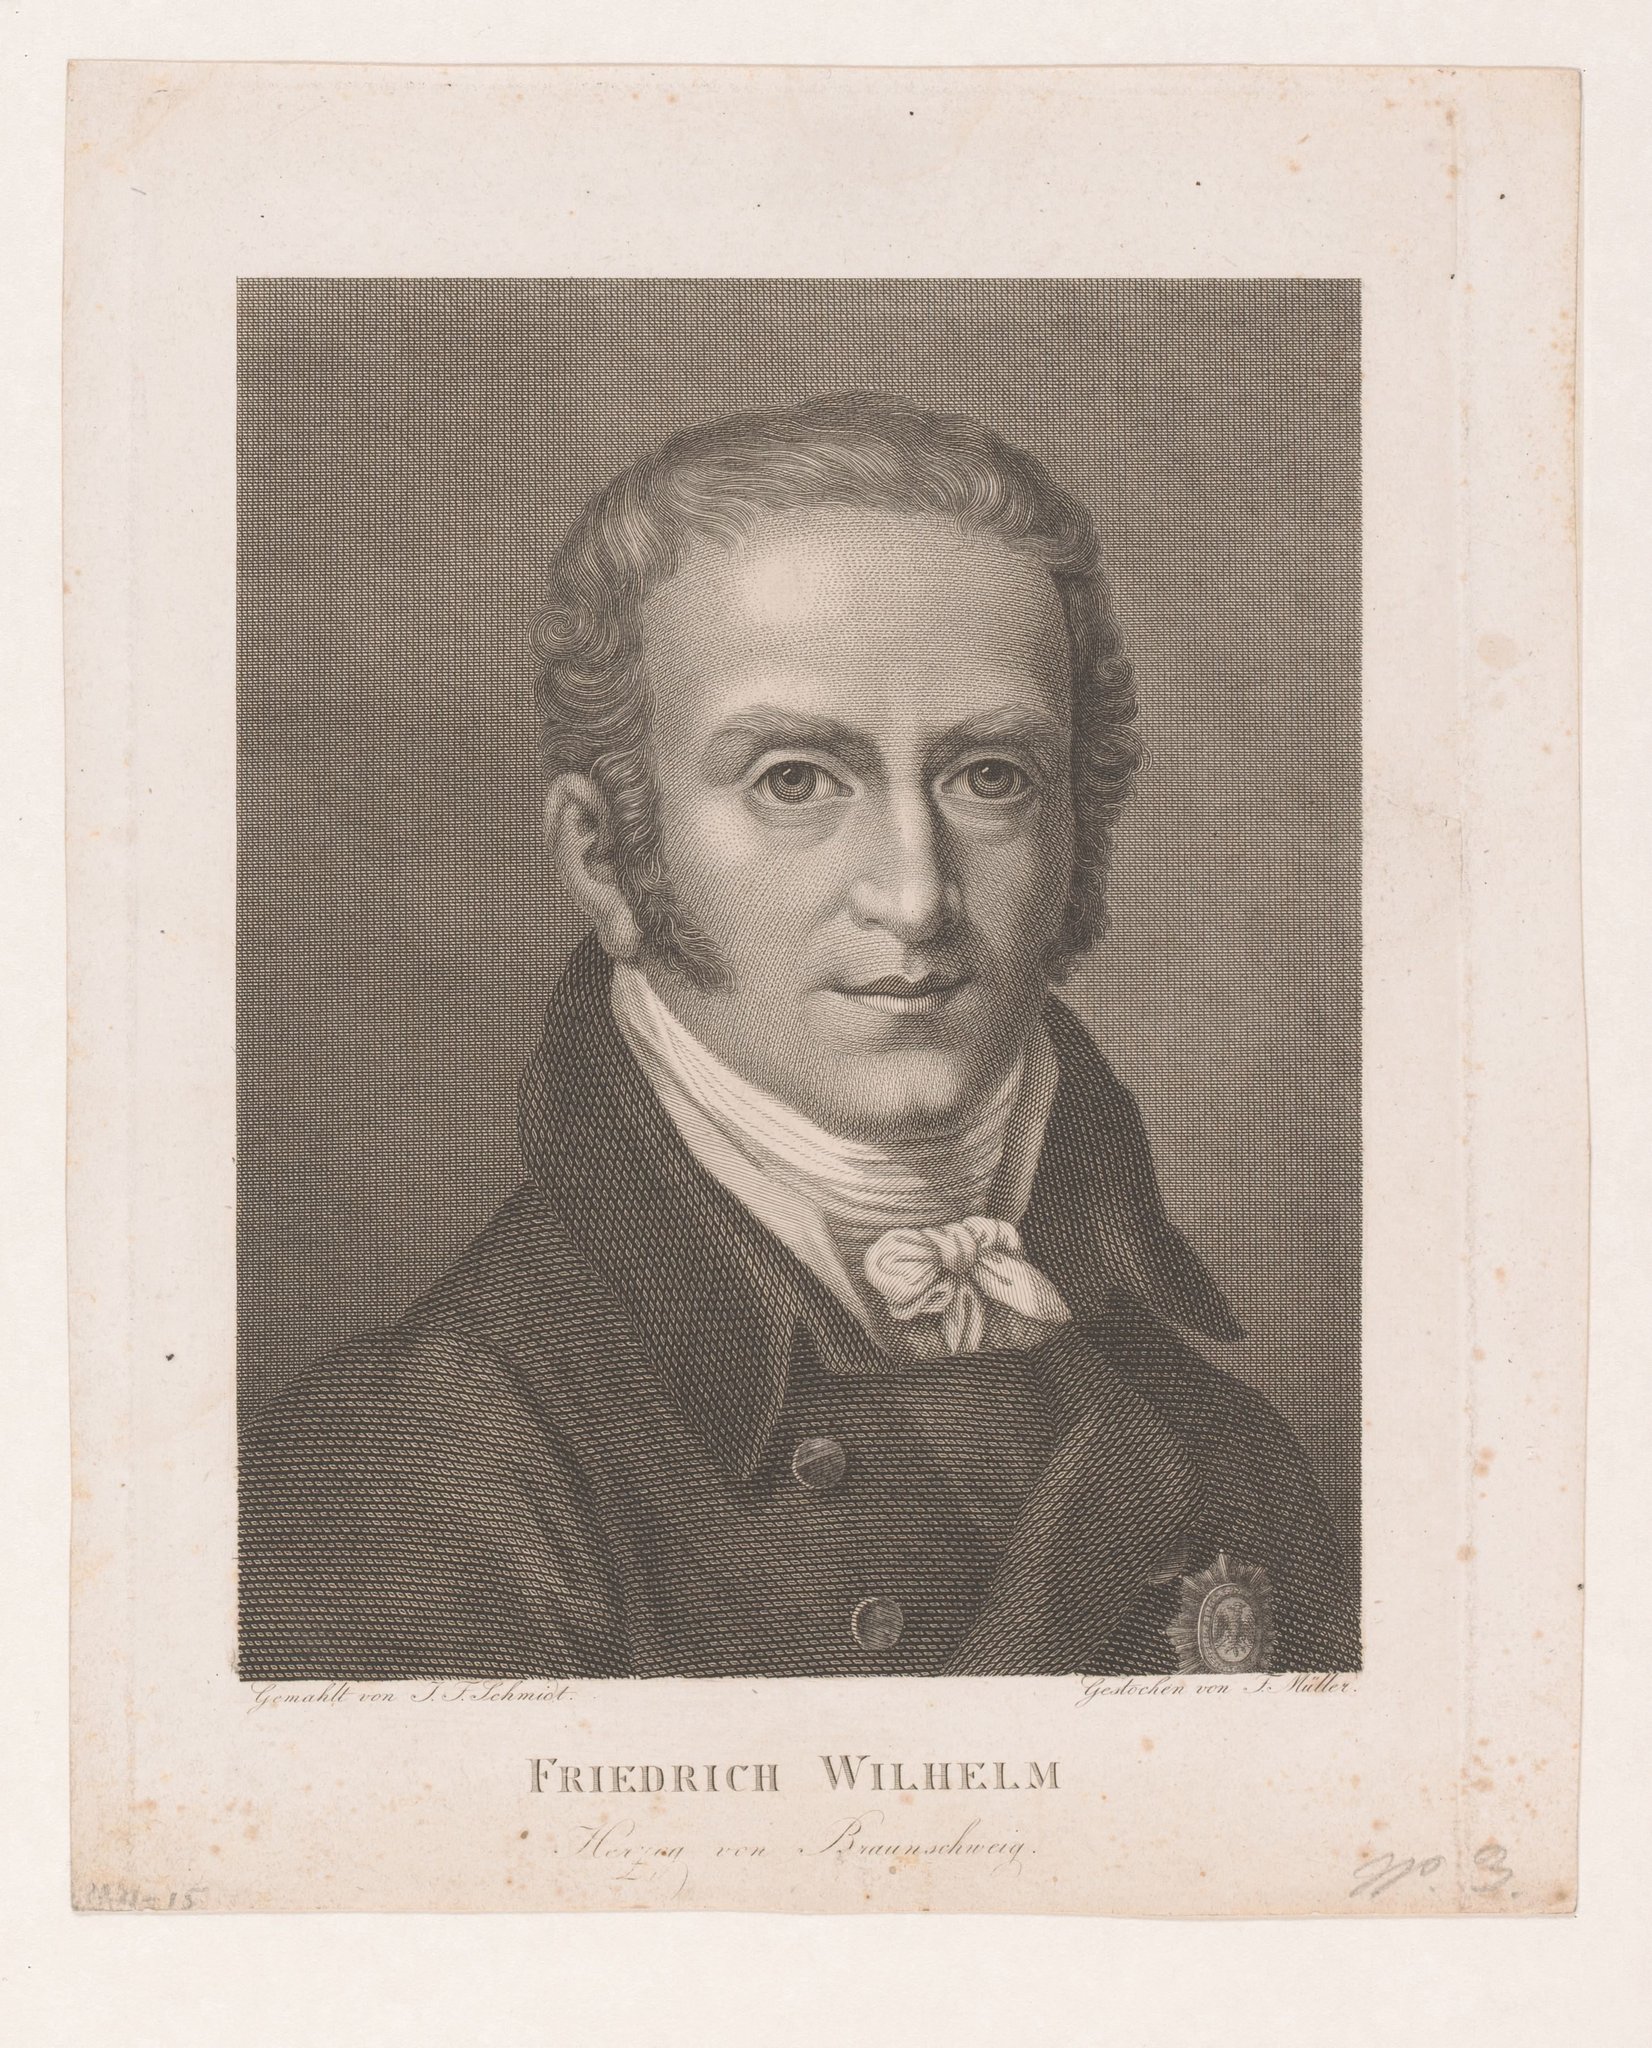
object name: print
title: Portret van Frederik Willem van Brunswijk-Lüneburg-Oels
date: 1792-1816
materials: paper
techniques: engraving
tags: knighthood order (red eagle order), historical persons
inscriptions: collector's mark: Lugt 2228